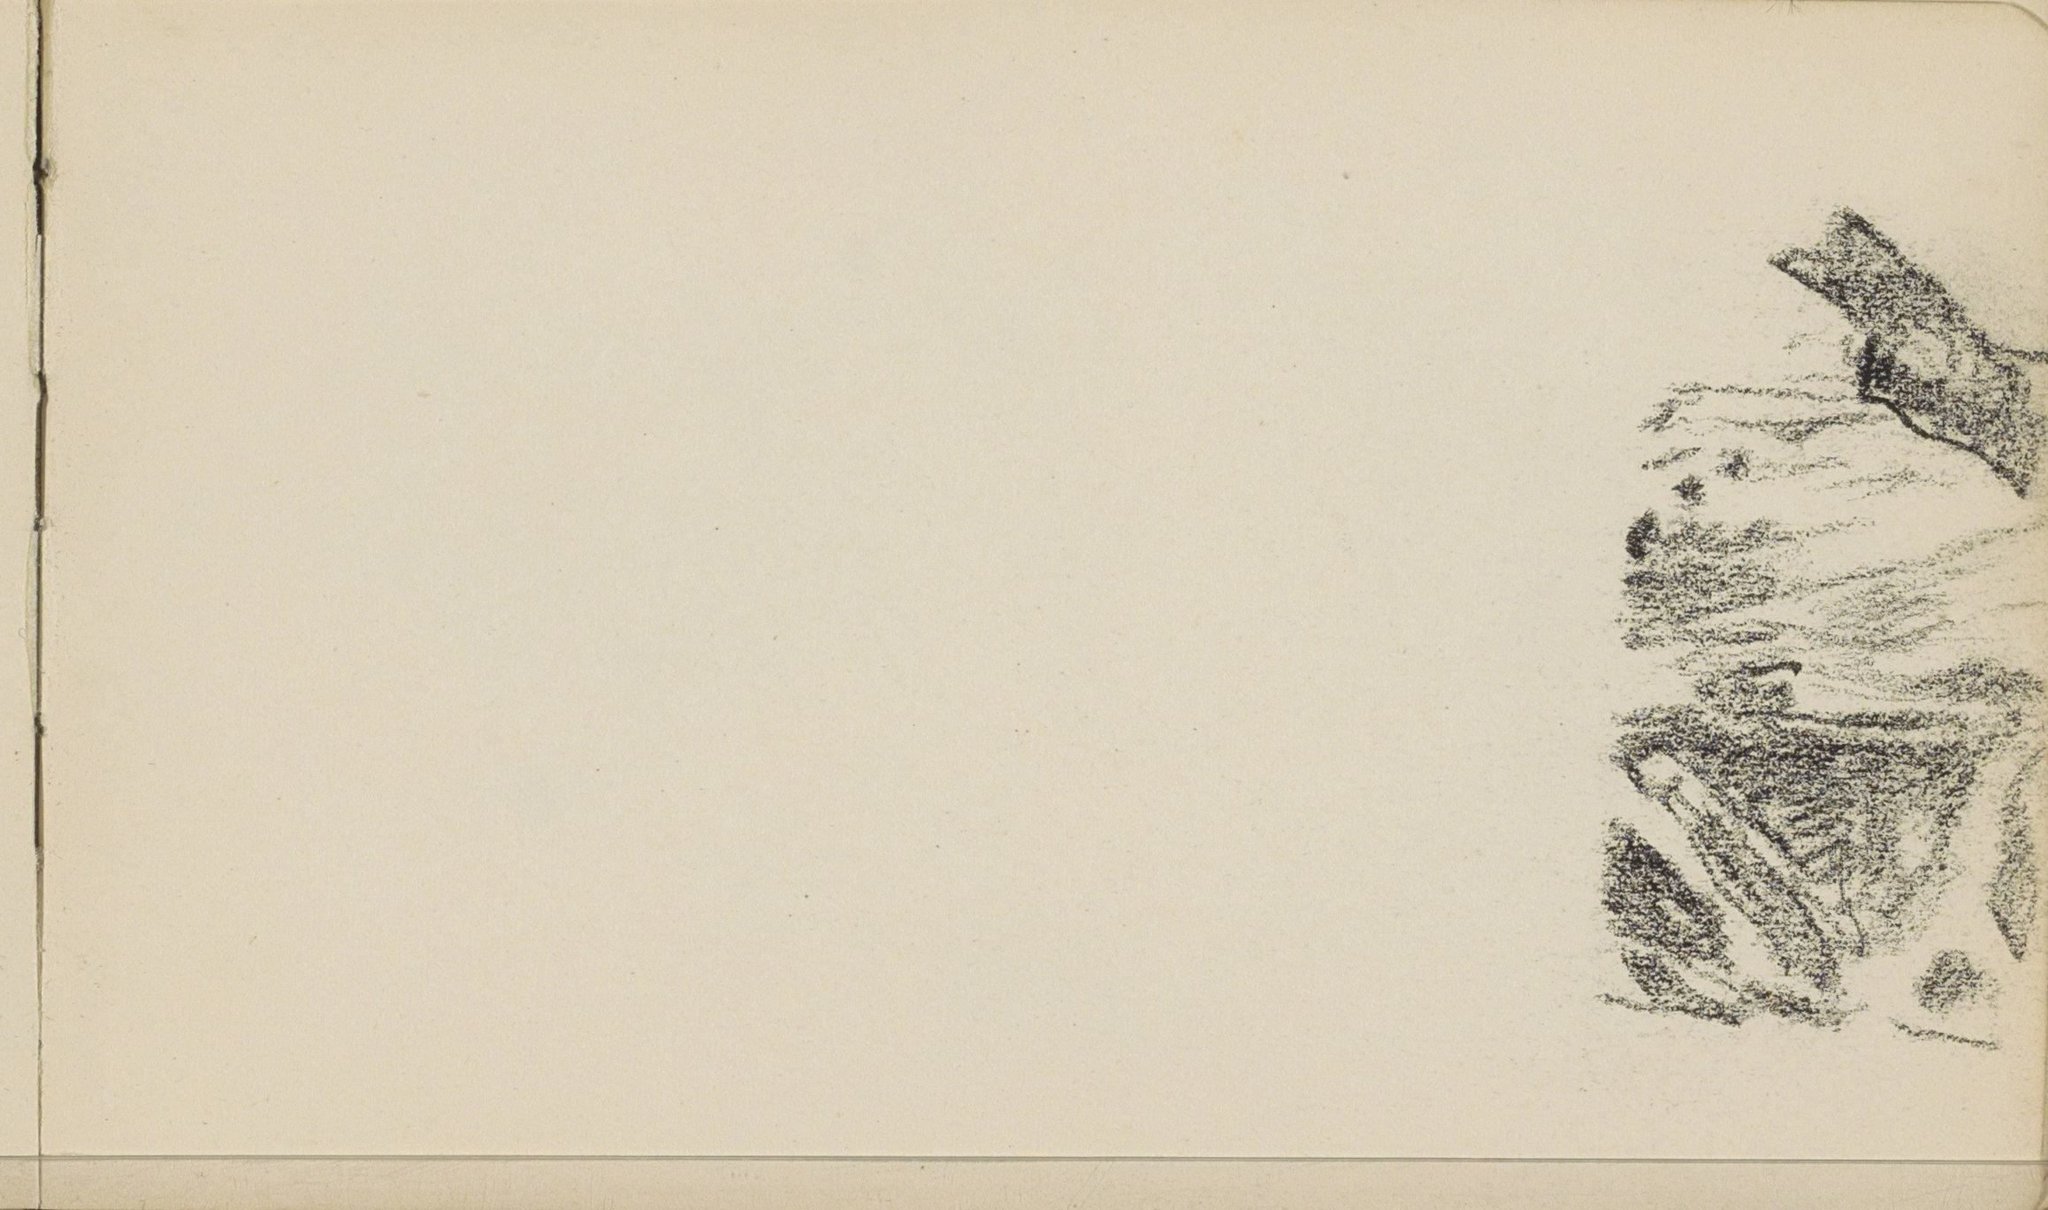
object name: sketchbook leaf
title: Landschap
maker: johan antonie de jonge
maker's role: draughtsman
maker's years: 1864-1927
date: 1881-1927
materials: chalk, paper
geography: south holland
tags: landscapes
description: Landschap. Blad 9 recto uit een schetsboek met 34 bladen.